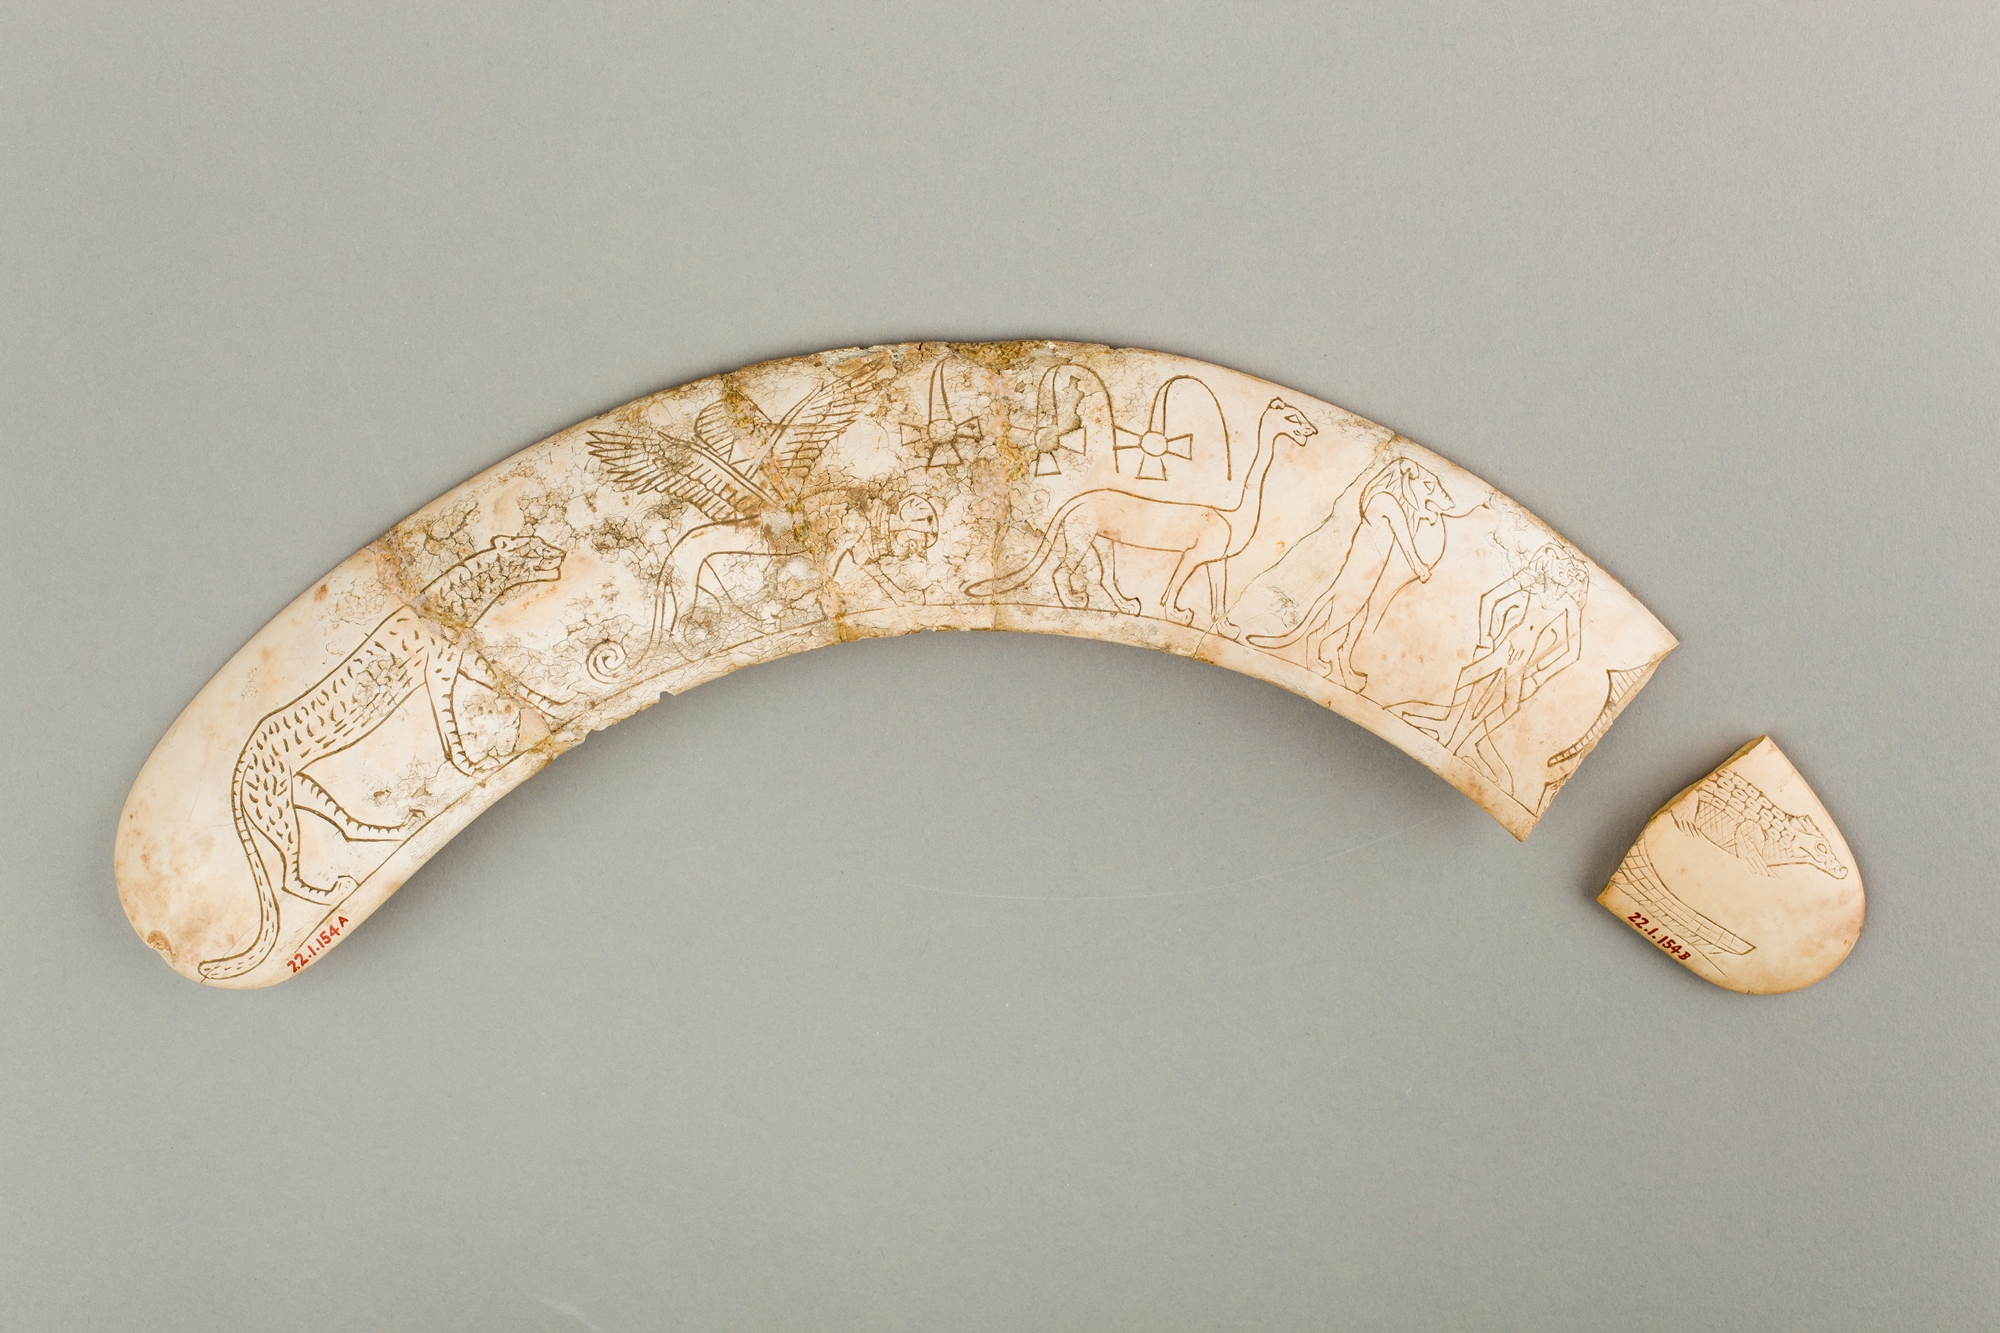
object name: magic wand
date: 1900-1640 BCE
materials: ivory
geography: egypt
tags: animals